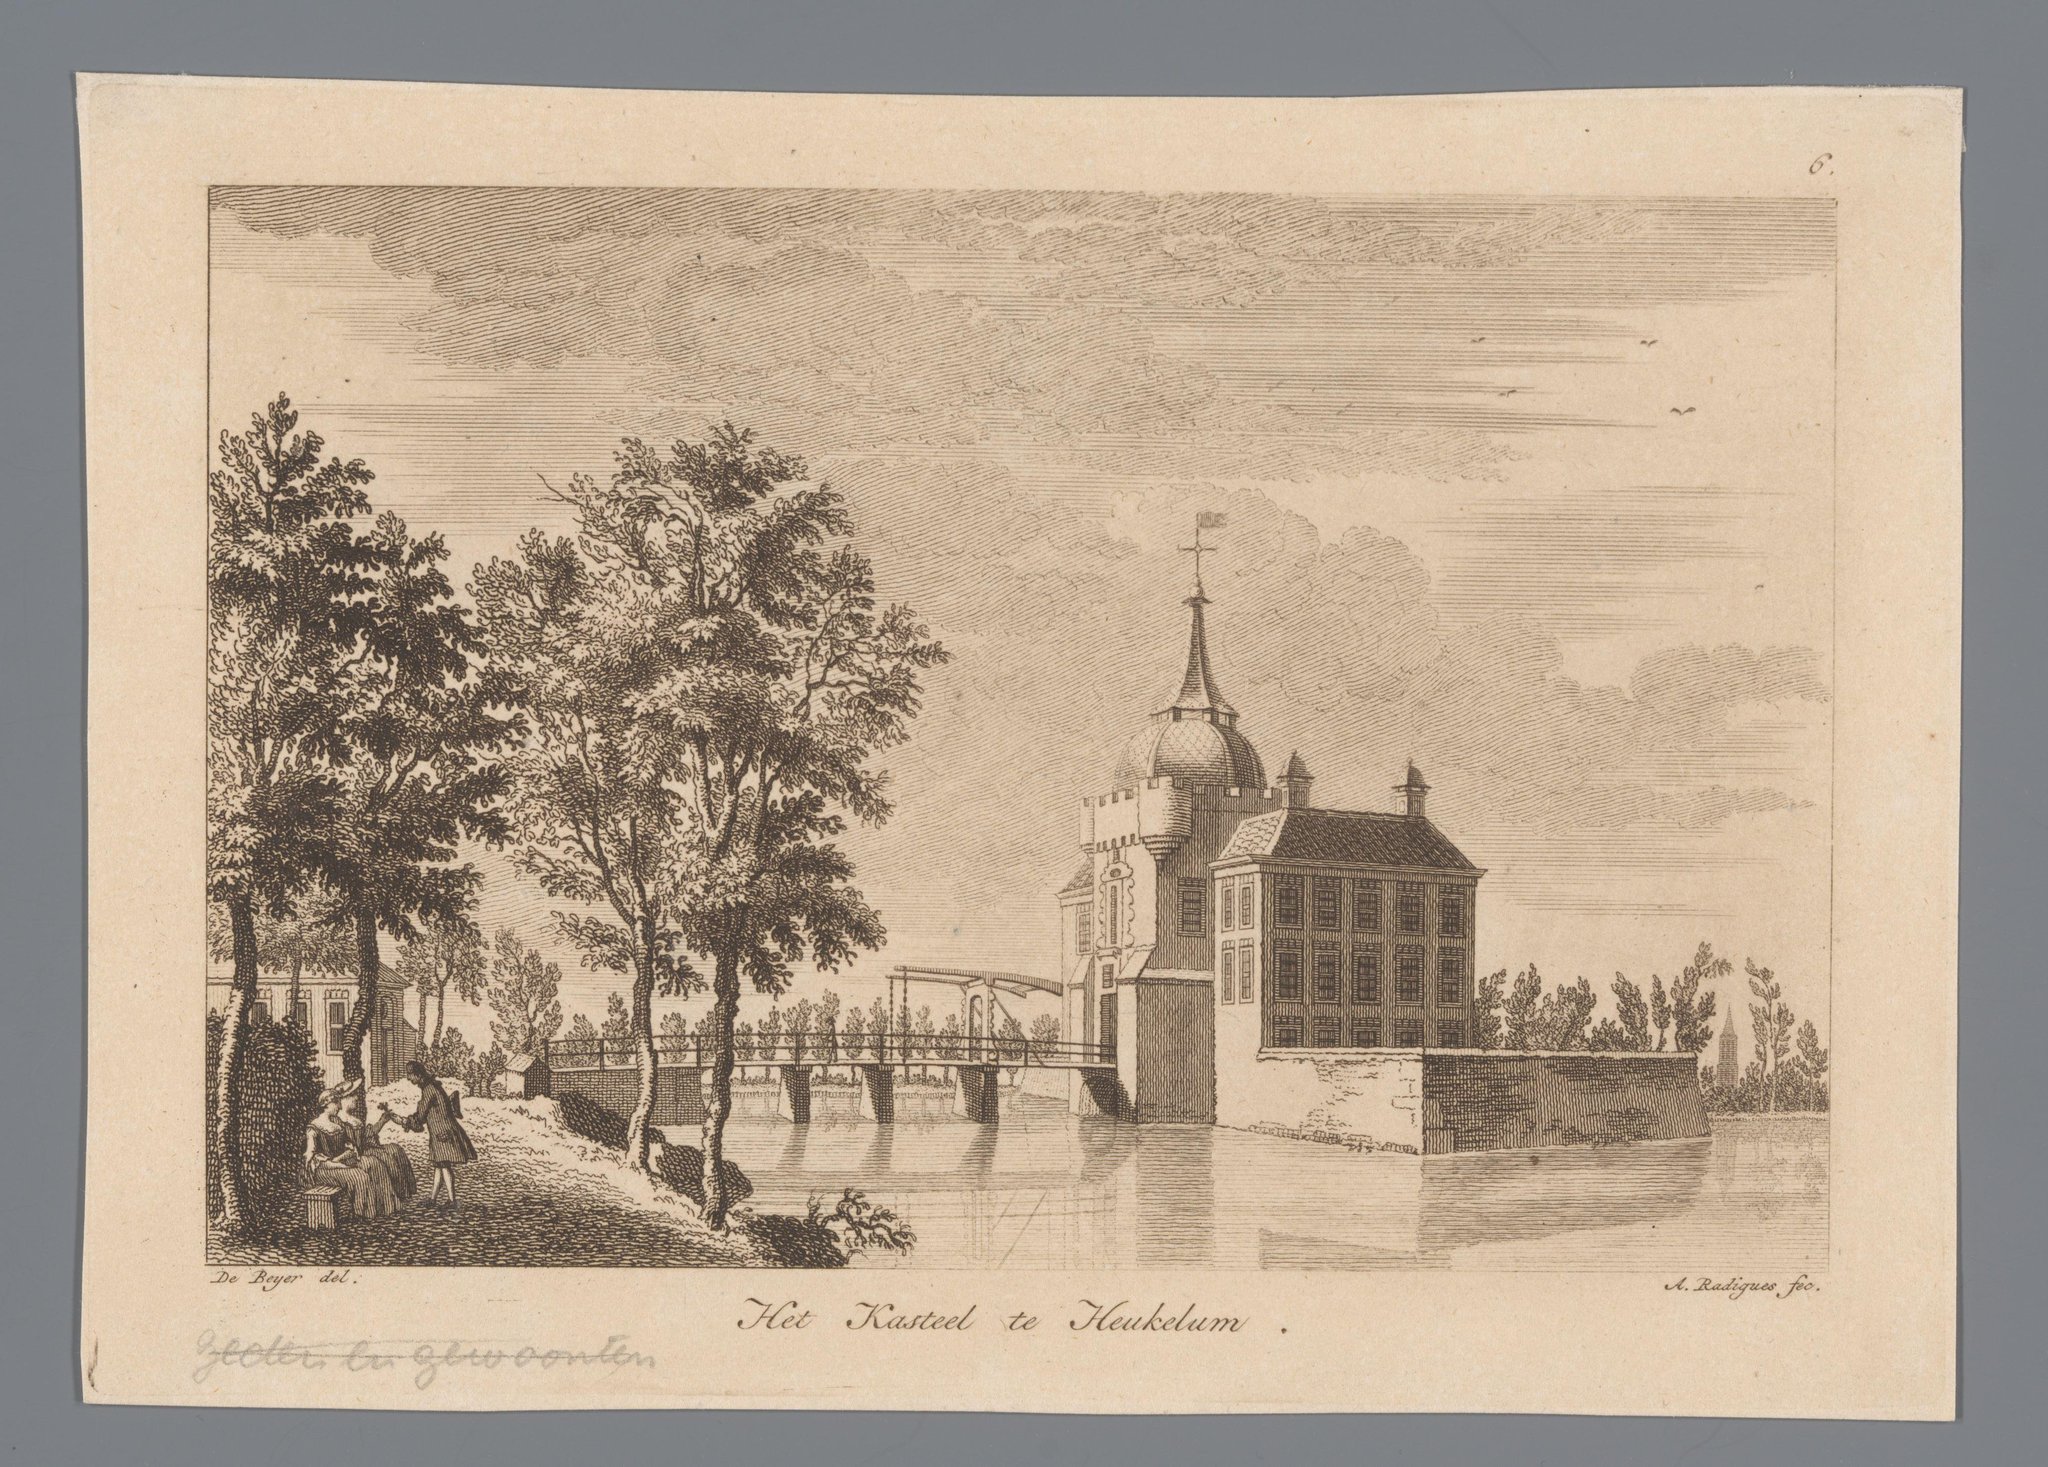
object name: print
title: Het Kasteel te Heukelum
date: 1750-1764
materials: paper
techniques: etching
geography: amsterdam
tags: landscape with tower or castle (+ city(-scape) with figures, staffage)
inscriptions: collector's mark: Lugt 2228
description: Deze prent is eerst verschenen in een reeks van twaalf prenten uitgegeven door Pierre Fouquet junior in de tweede helft van de achttiende eeuw. Deze reeks bestond uit prenten van: Spijk, Nieuwland, Heukelum (3x), Ensapijk, Leerdam, Deil, Gellicum, Asperen, Acquoy en Craijenstein (bij Tricht). Later zijn deze prenten gebruikt in: Gezigten van voornaame Hollandsche dorpen. Amsterdam: Evert Maaskamp, [ca. 1775-1800].